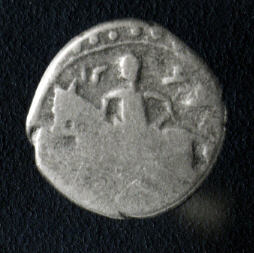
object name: coin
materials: copper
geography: iran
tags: horses